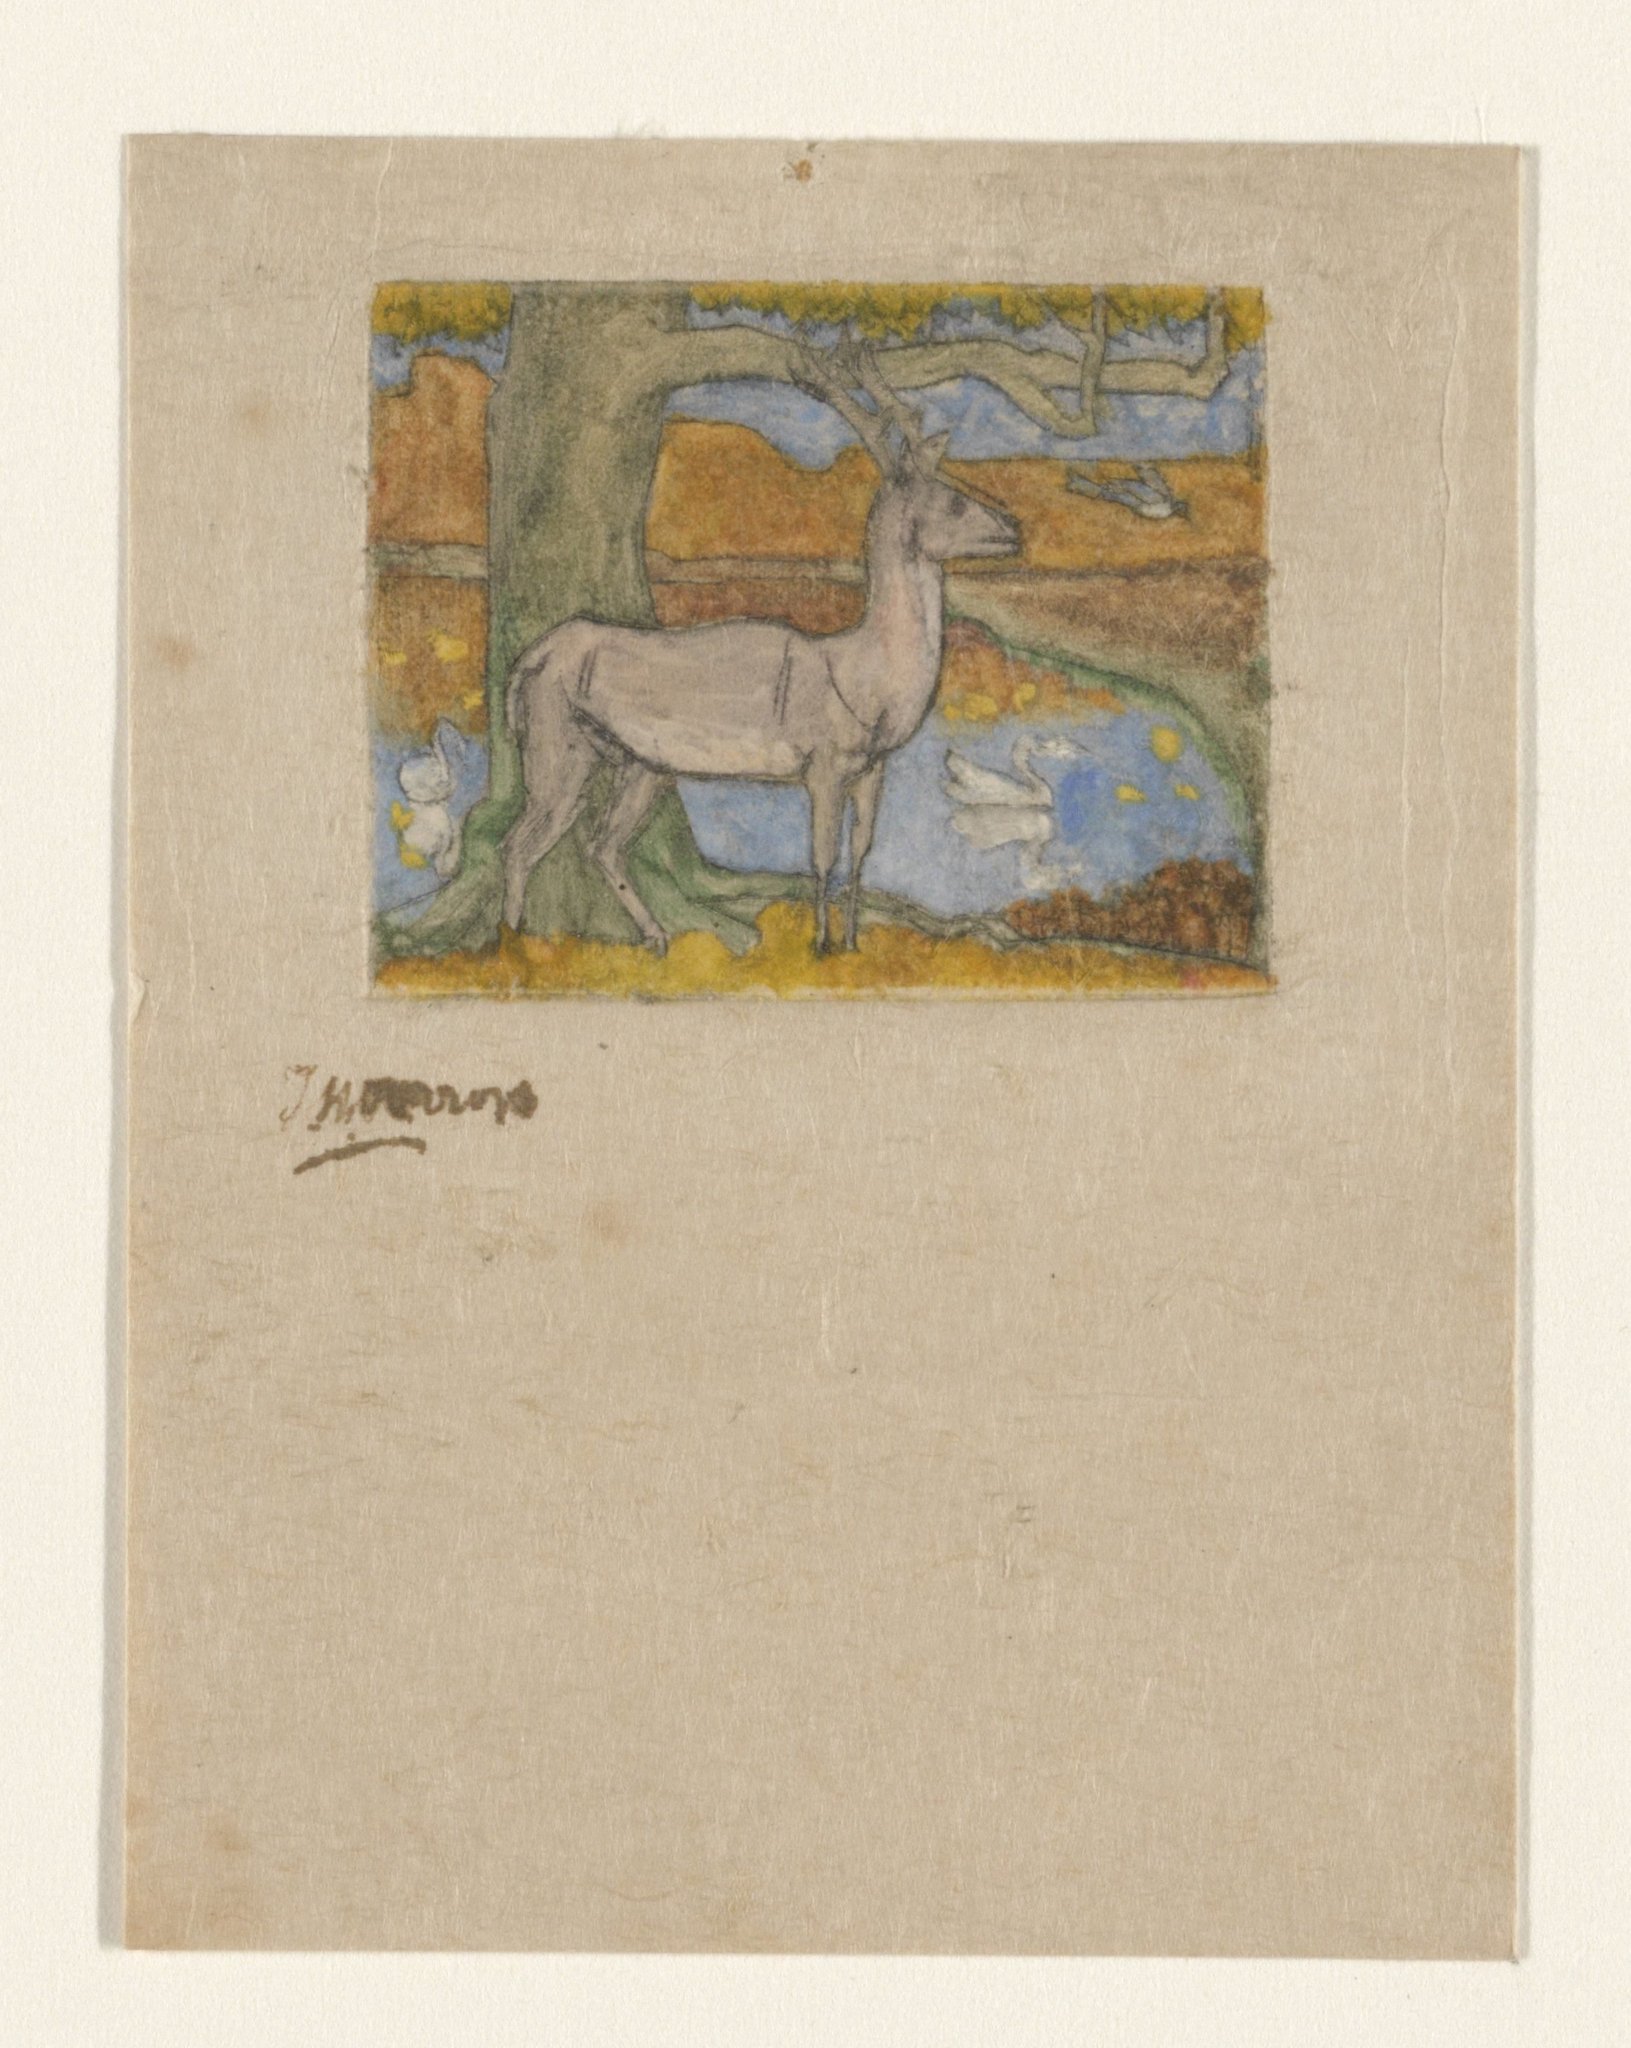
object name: print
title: Hertje bij een boom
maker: jan toorop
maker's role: draughtsman, painter, print maker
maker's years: 1858-1928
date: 1895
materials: paper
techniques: drypoint, hand coloring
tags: hoofed animals: deer, pond, pool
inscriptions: collector's mark: Lugt 2760, collector's mark: Lugt 2228